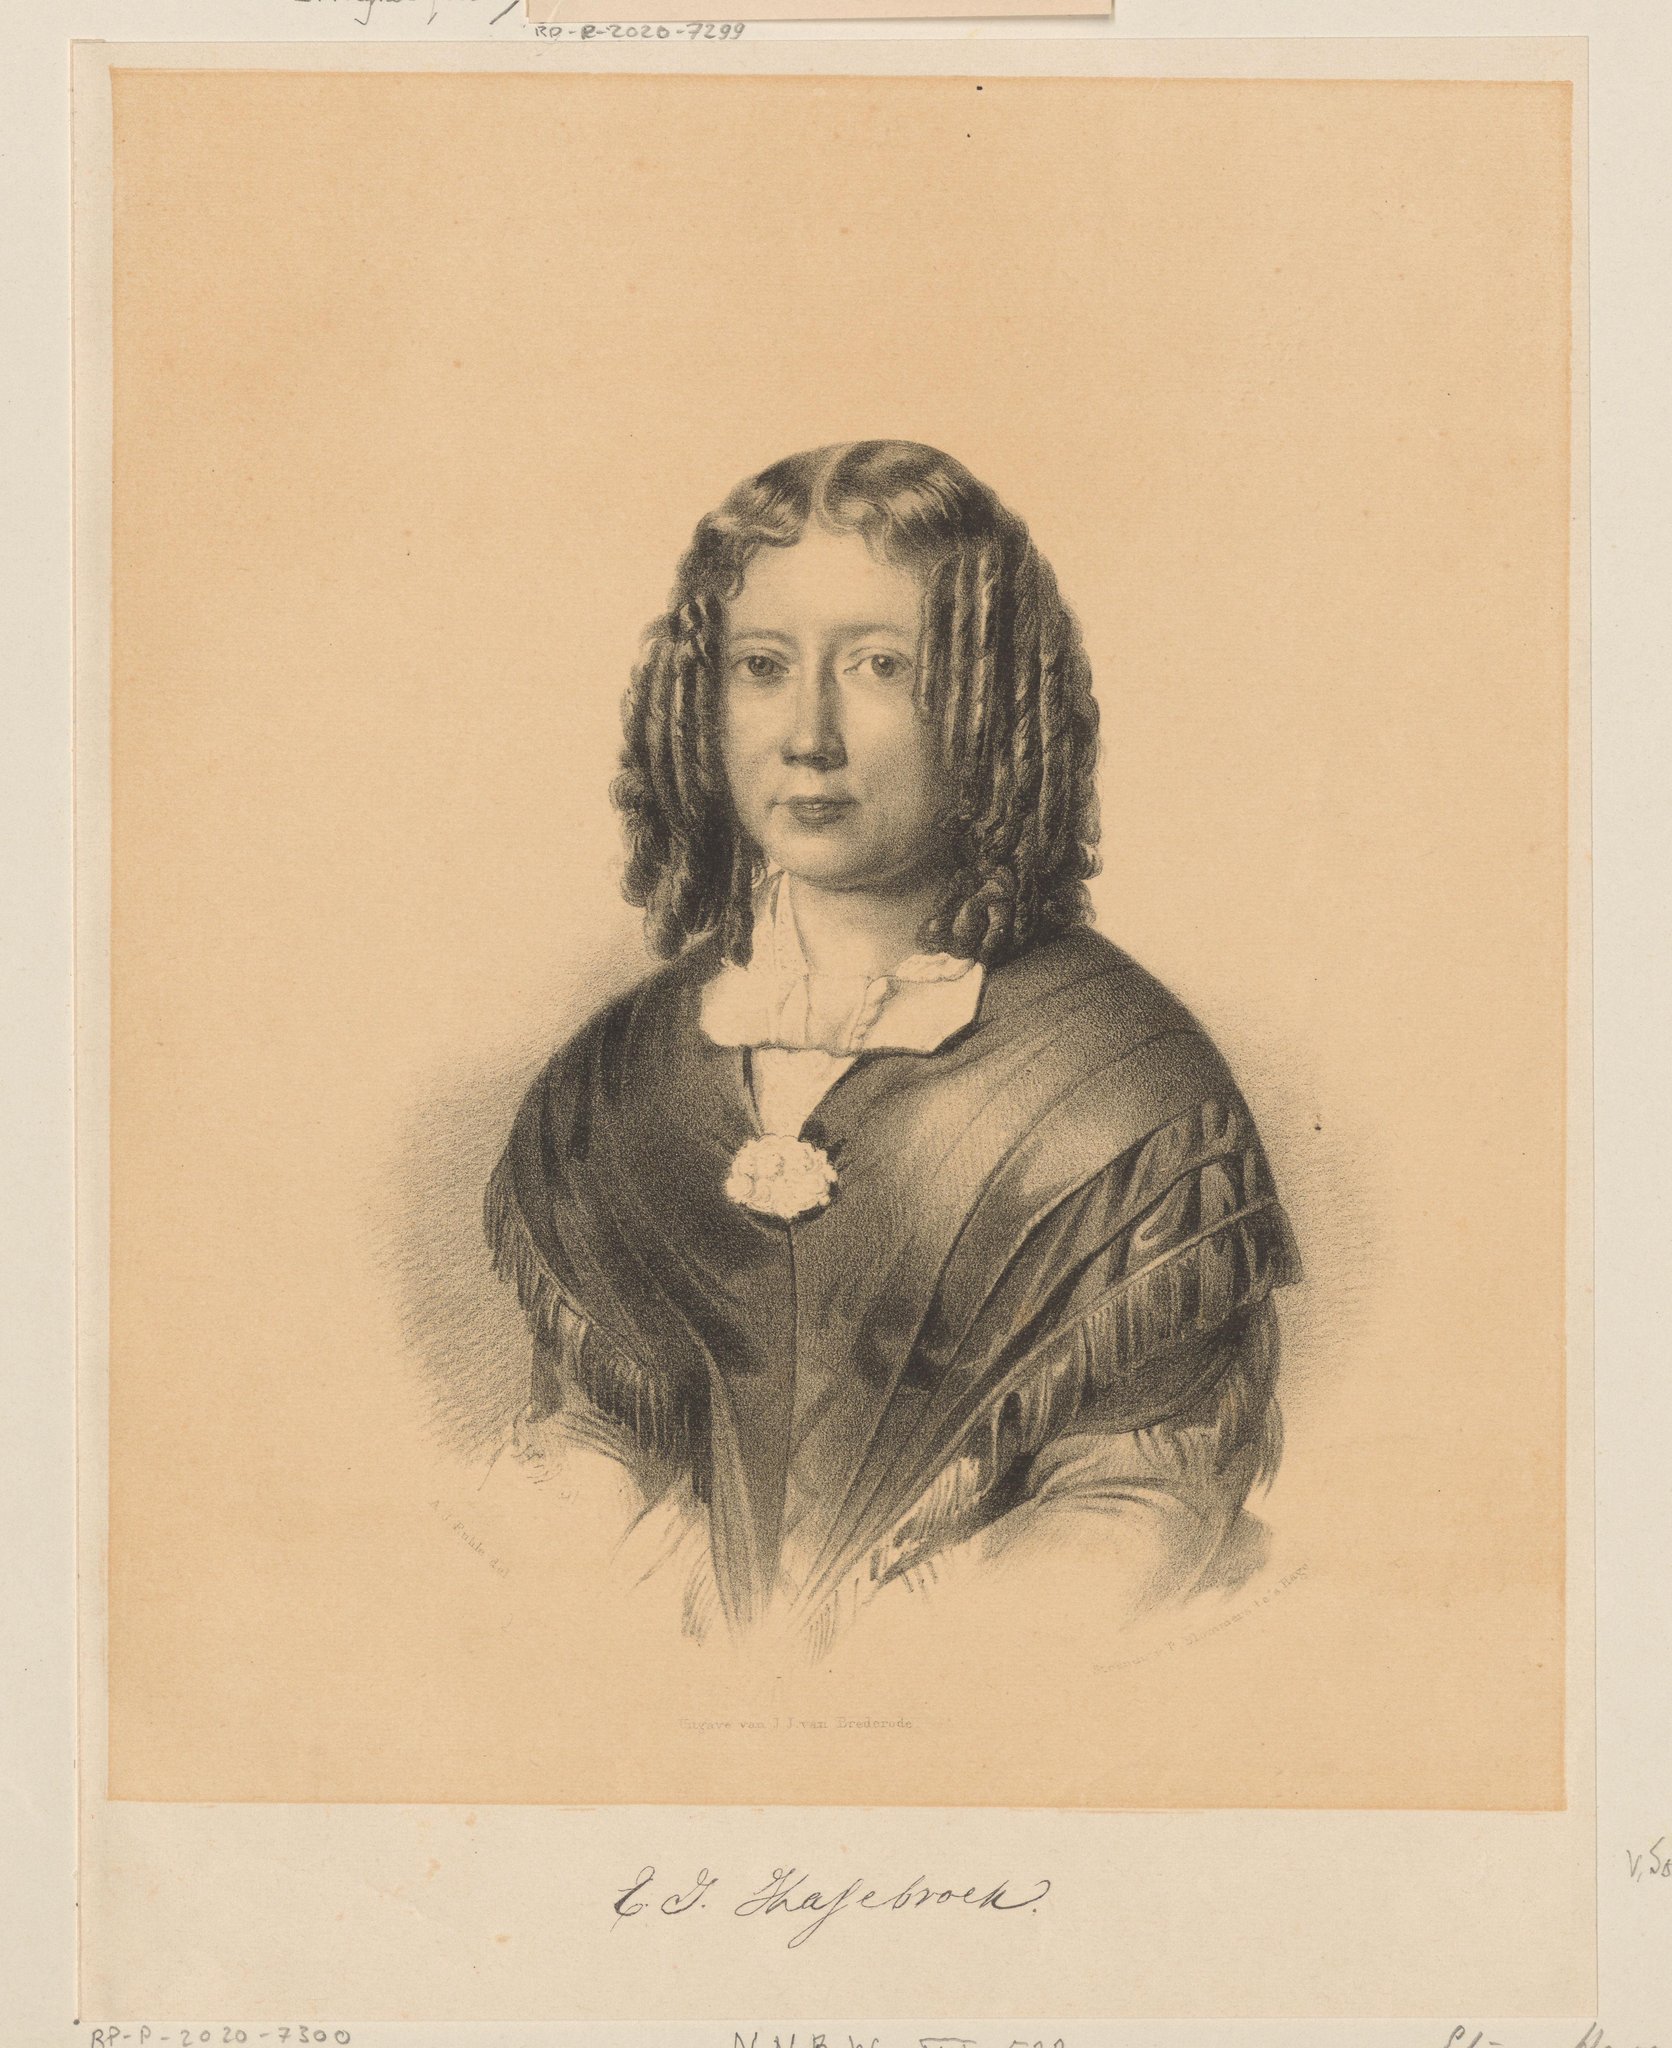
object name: print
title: Portret van Elisabeth Johanna Hasebroek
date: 1847-1883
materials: paper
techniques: tone lithography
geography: the hague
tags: historical persons - bb - woman, portrait of a writer